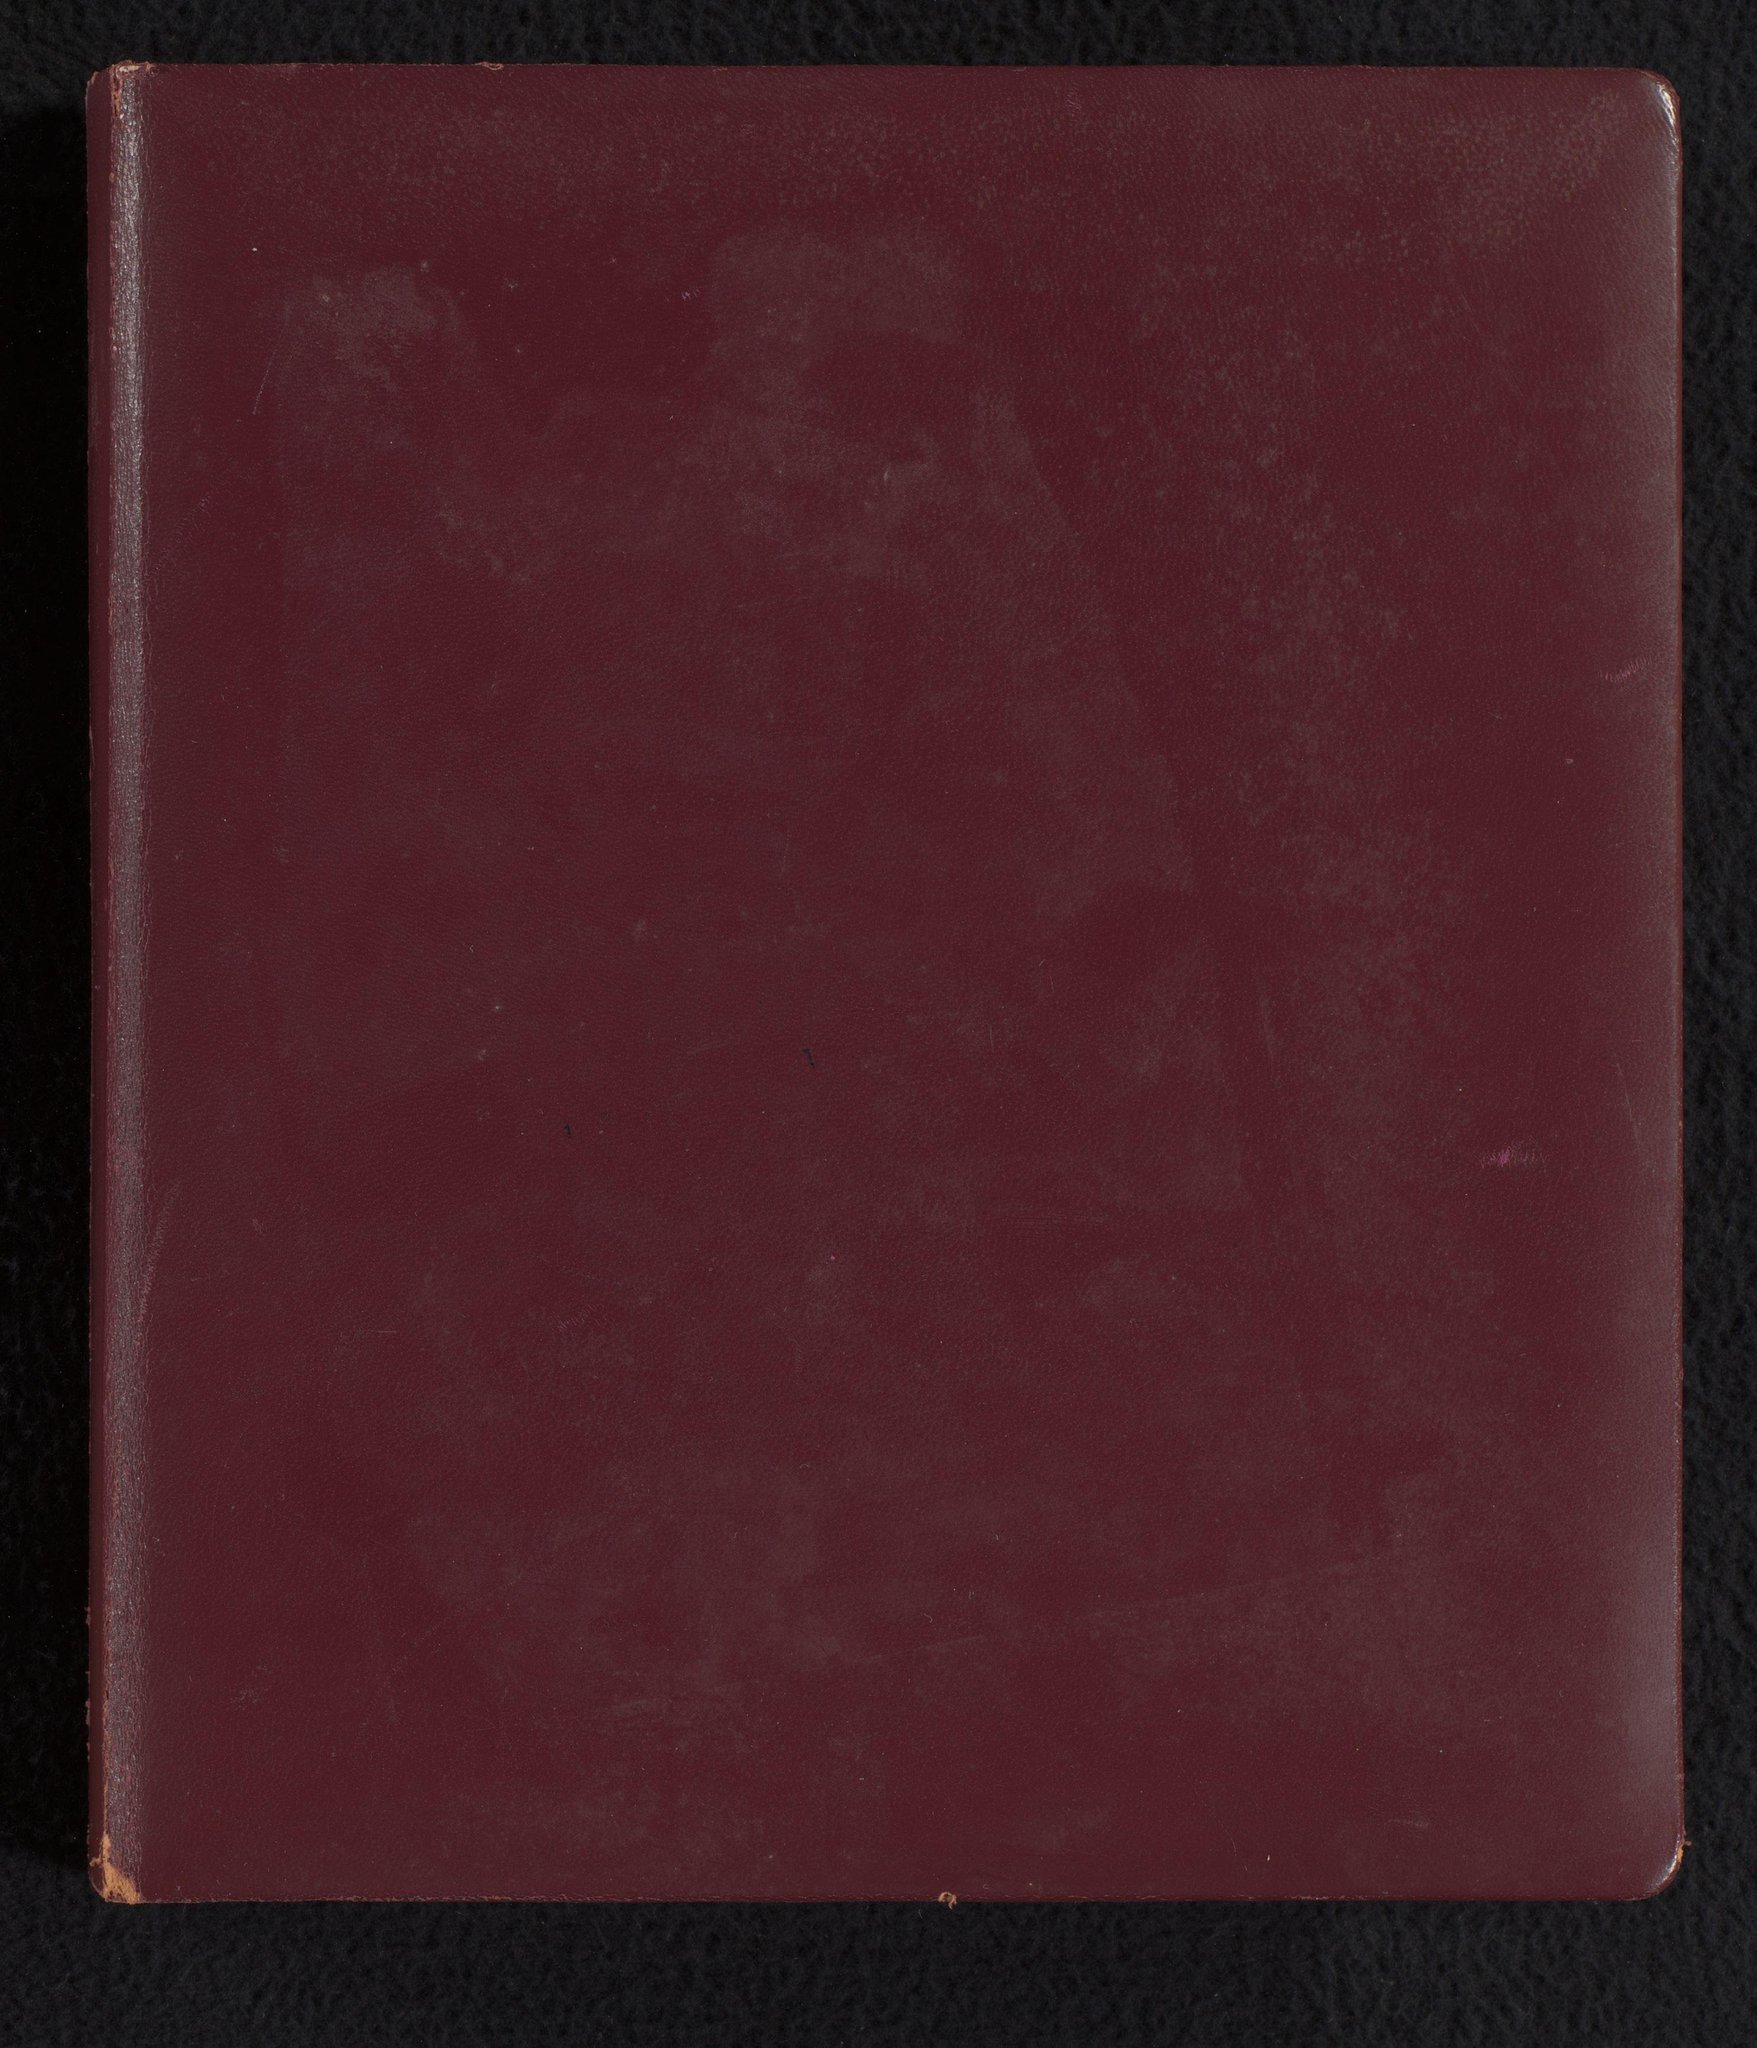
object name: photograph album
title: Fotoalbum met foto's van het leven van Willem Jacob van den Berg in Zuid-Afrika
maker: willem jacob van den berg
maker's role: boer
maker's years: 1902-1983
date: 1967-1971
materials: paper, cardboard, leather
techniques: gelatin silver print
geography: south africa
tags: norbert van den berg (1901-1972), amsterdam, willem jacob van den berg, family life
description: Fotoalbum met 143 foto's, waaronder 42 losse foto's, van het leven van Willem Jacob van den Berg in Zuid-Afrika, op 48 bladen.